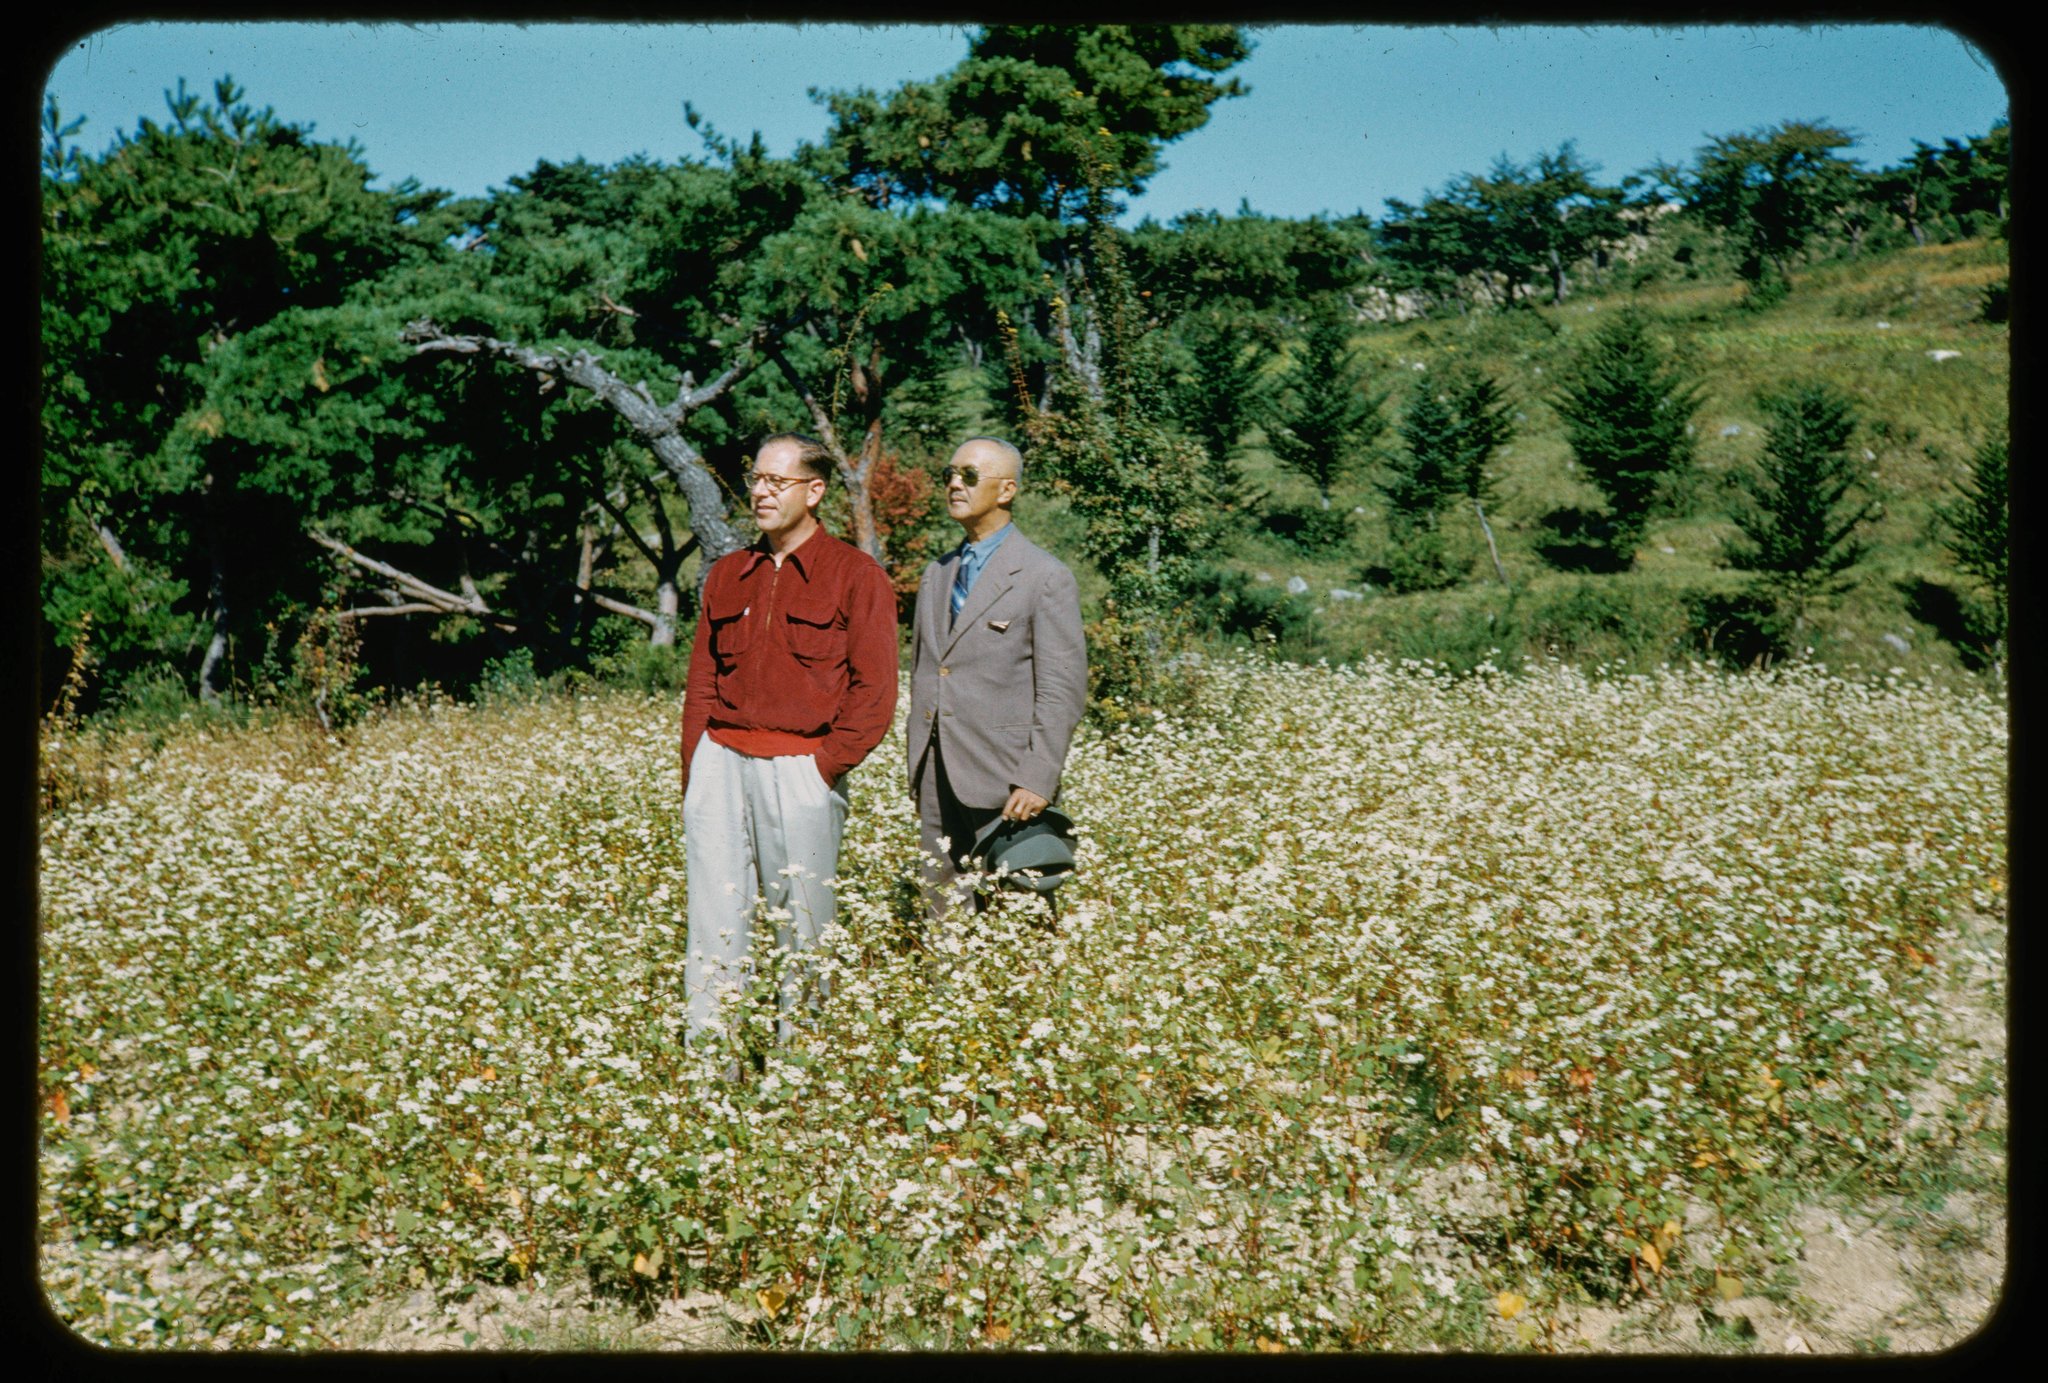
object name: color slide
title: David Ketel met de Koreaanse Prins Fridi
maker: david ketel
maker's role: diplomaat, sinoloog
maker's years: 1913-2008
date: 1952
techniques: slide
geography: korea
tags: united nations